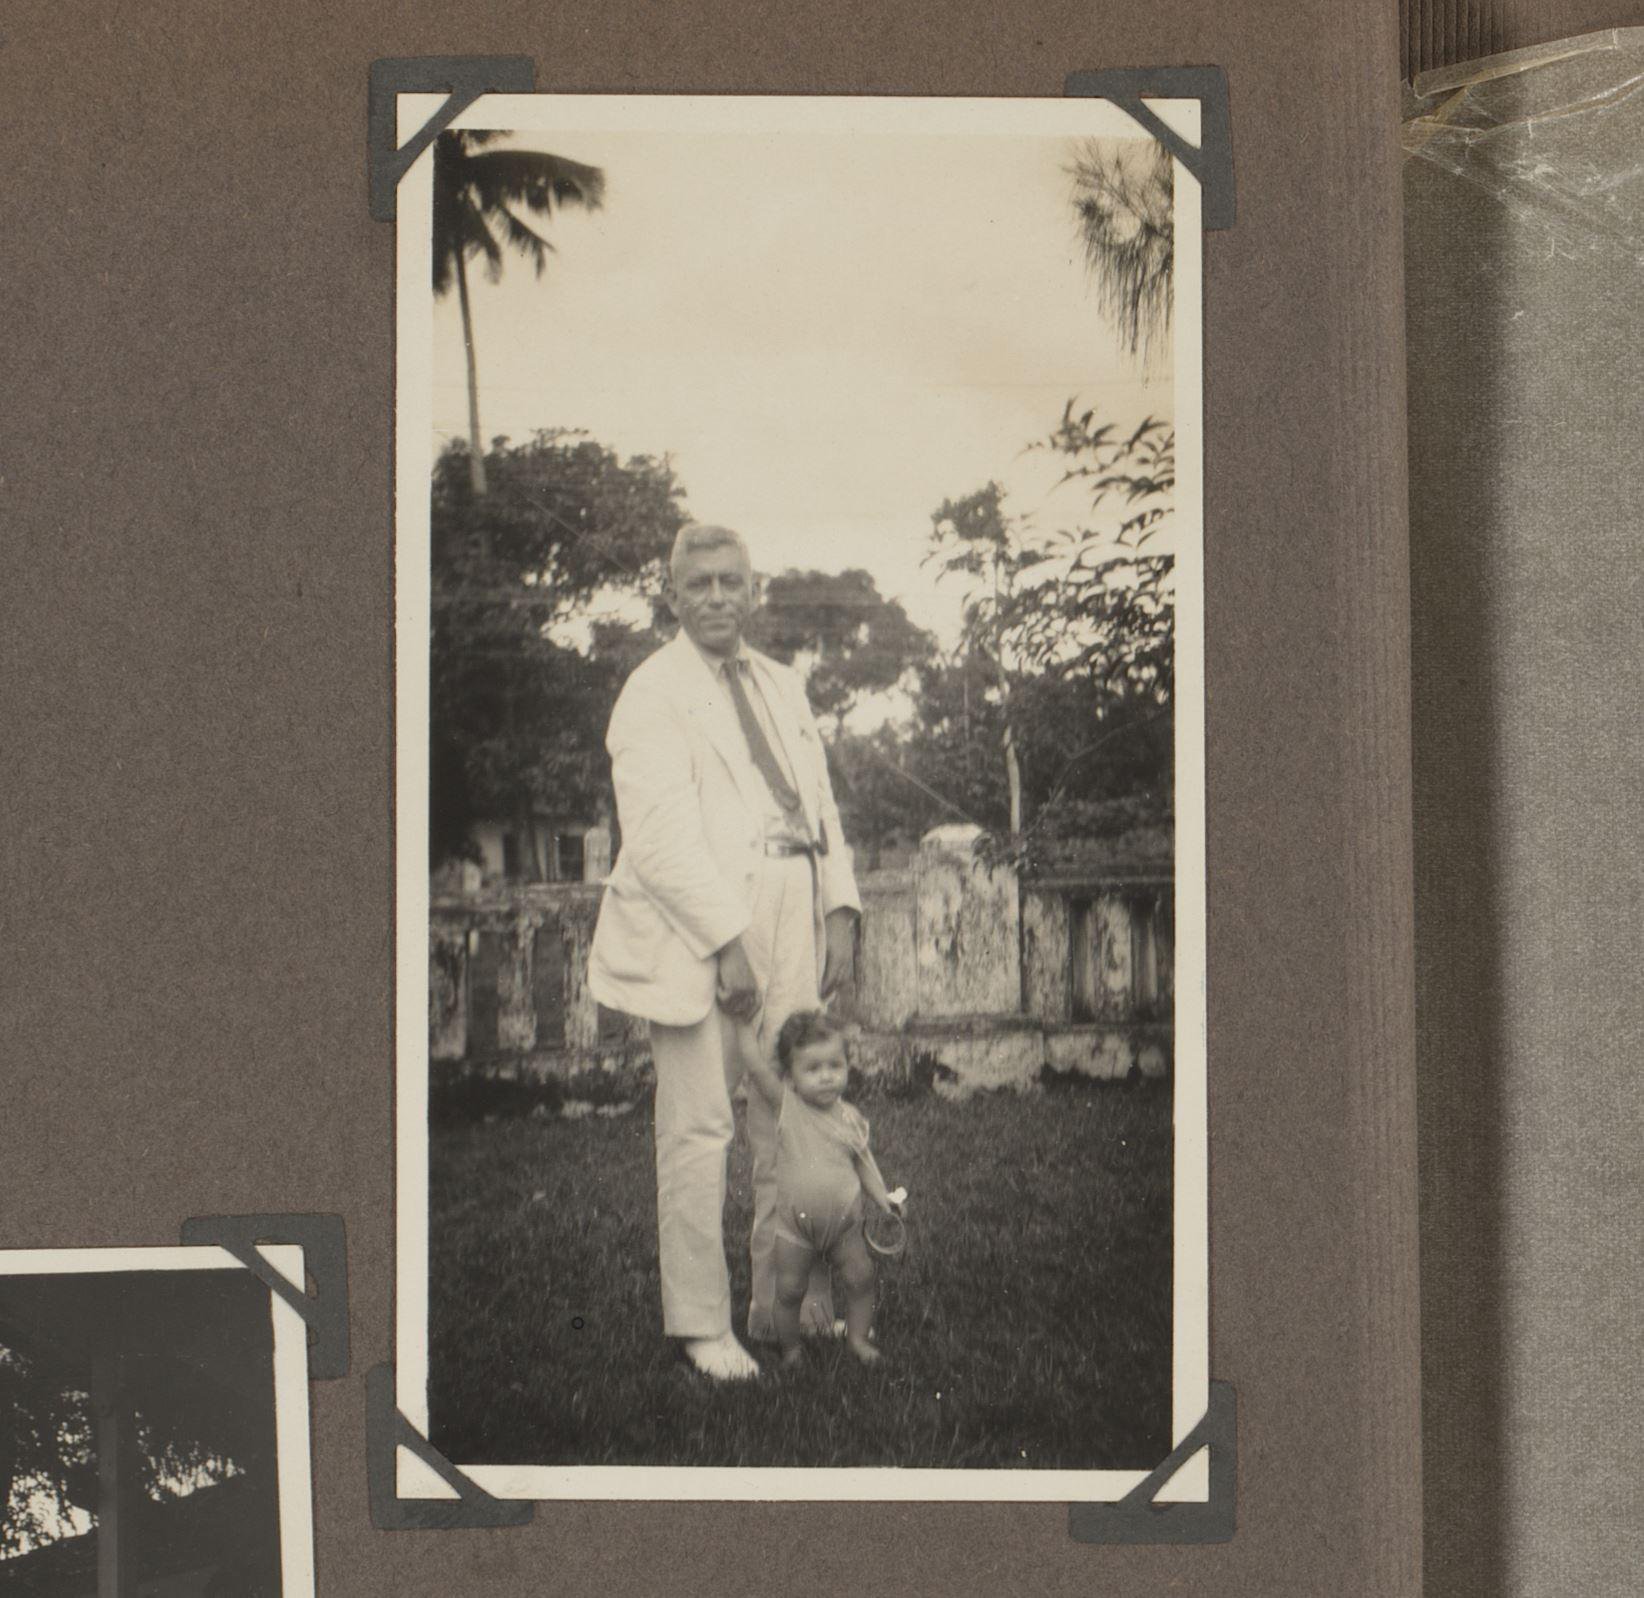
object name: photograph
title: Man met kind in een tuin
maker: Anonymous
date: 1930-1935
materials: paper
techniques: gelatin silver print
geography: dutch east indies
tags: adult man, tot, toddler ~ the ages of man, dutch east indies, the